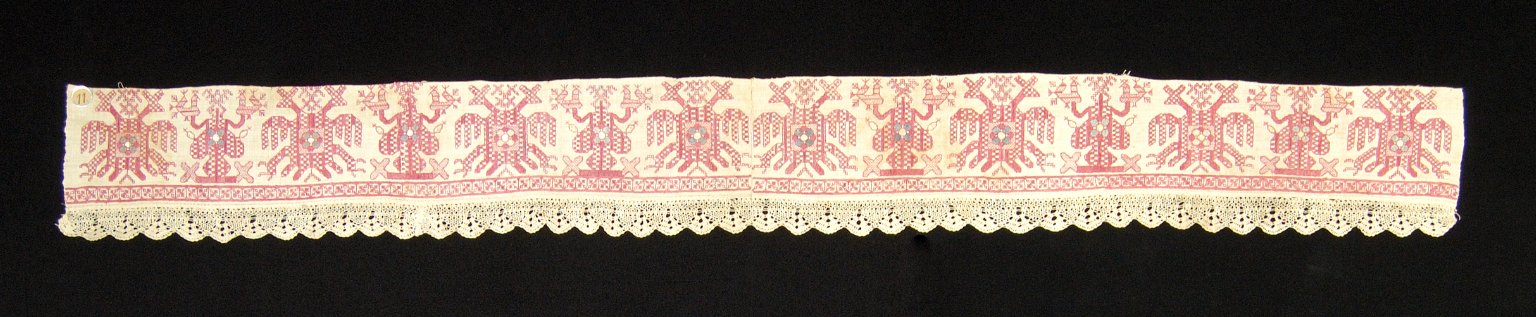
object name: border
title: Bed curtain border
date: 1800-1850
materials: cotton, linen